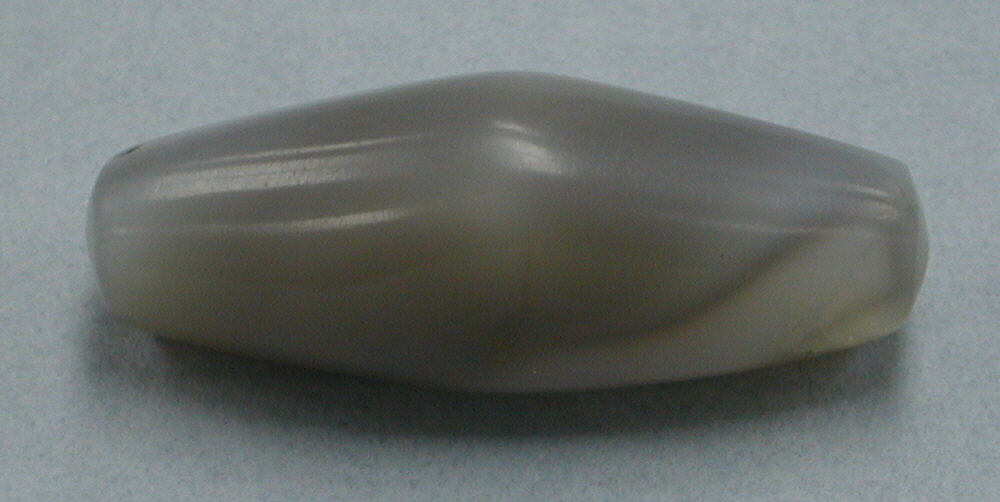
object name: ritual stone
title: Stone Pulidor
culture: mexican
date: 1501-1600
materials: stone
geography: mexico